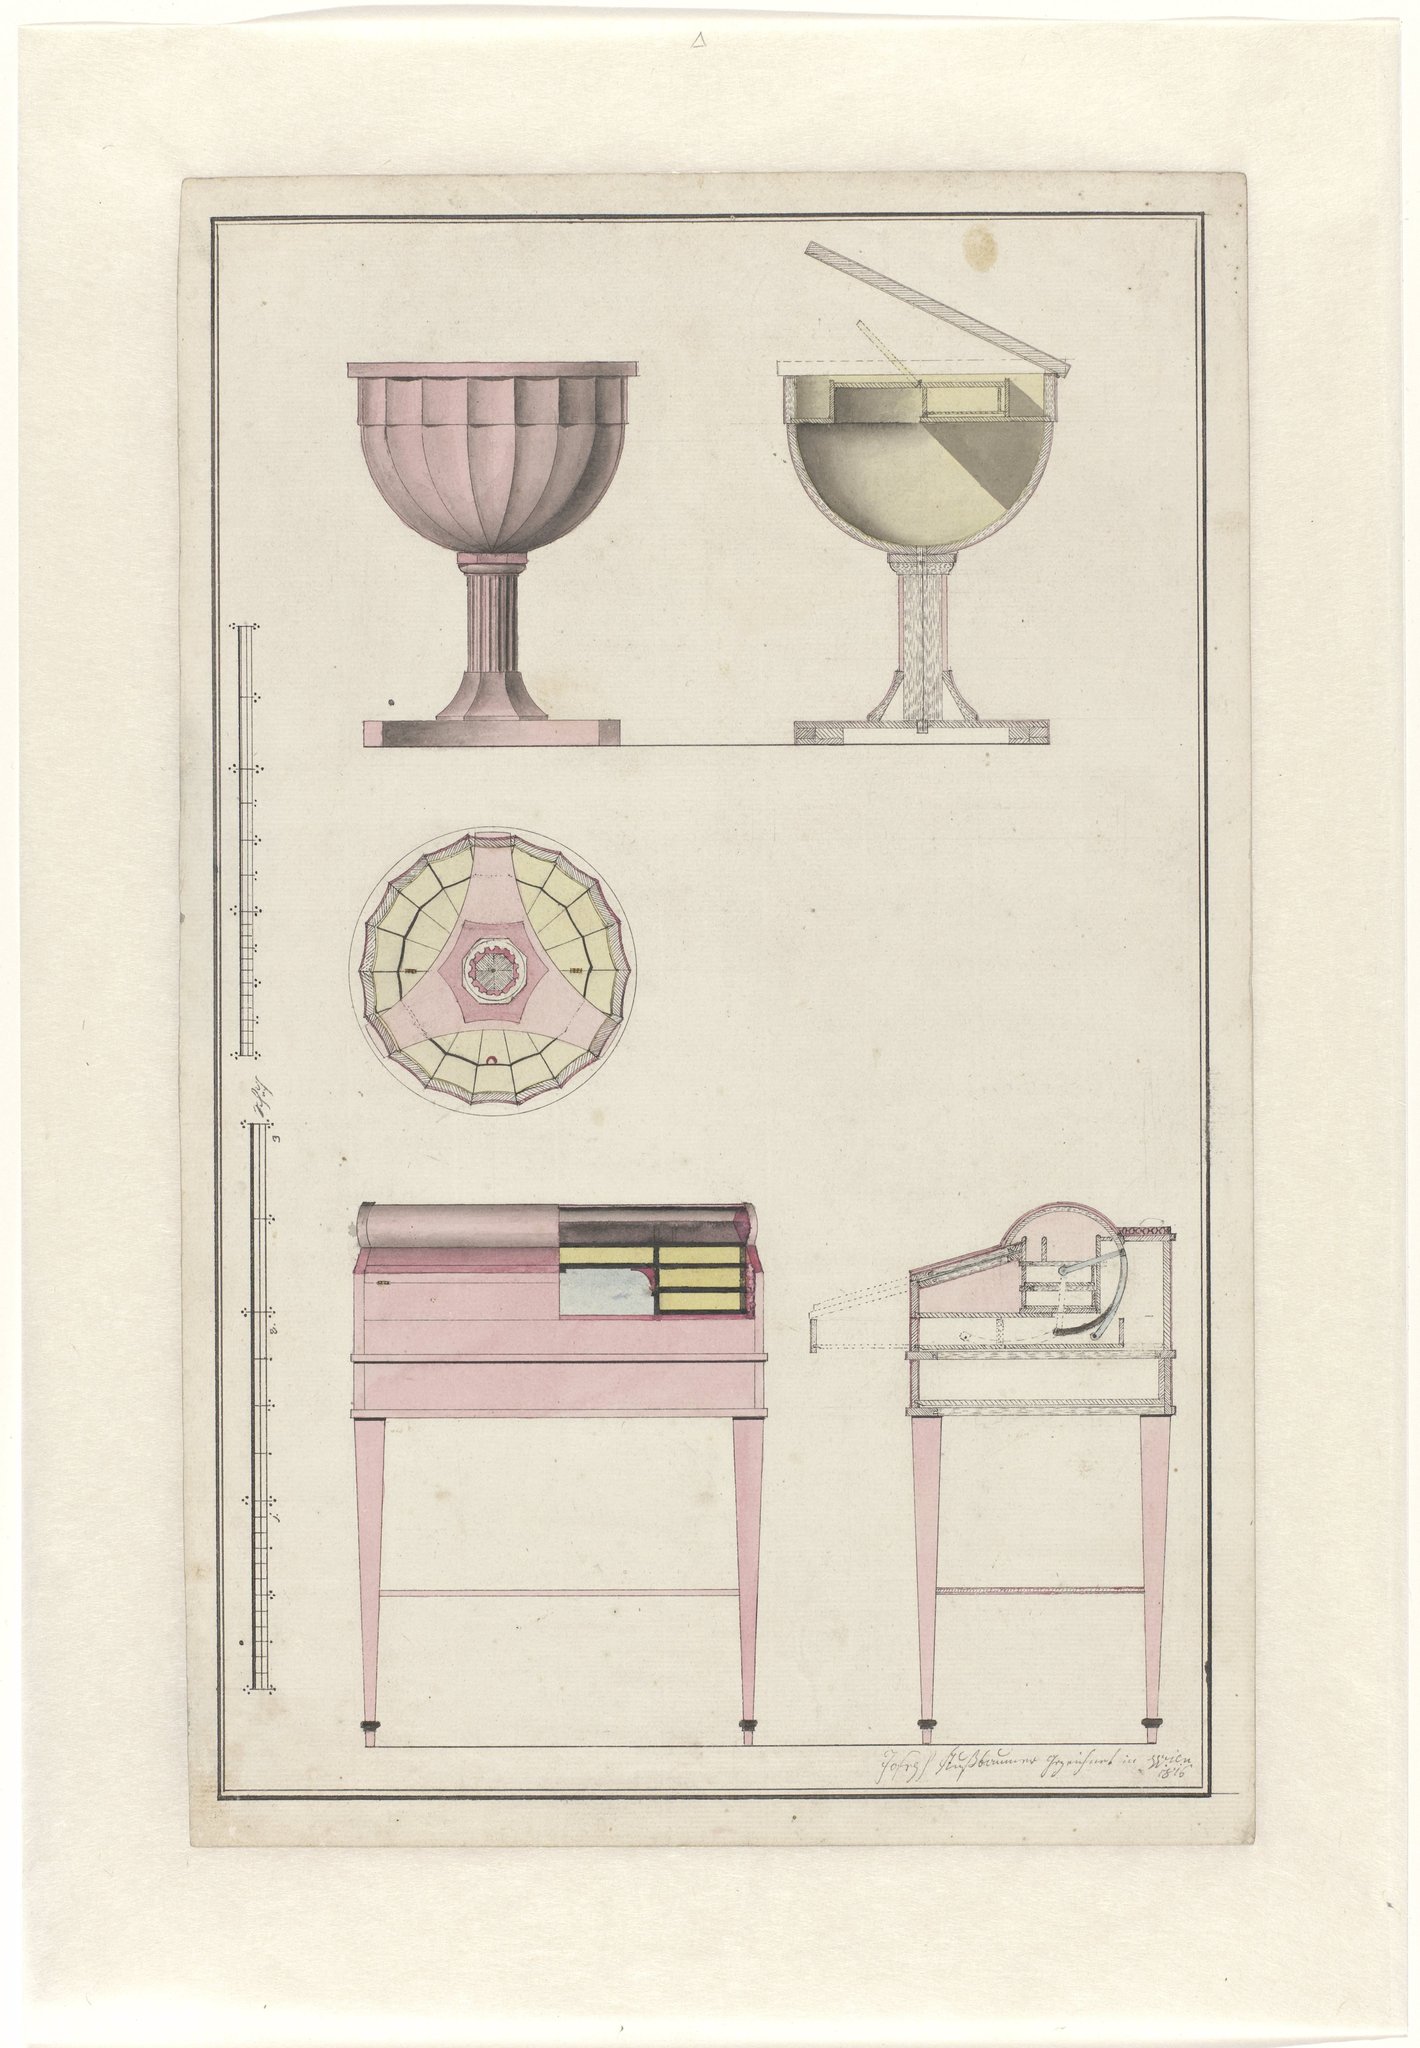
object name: design drawing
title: Ontwerp voor ronde naaitafel en bureau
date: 1816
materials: ink, paper, watercolor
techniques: brush, pen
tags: writing-table, writing-desk, furniture for storage, sewing box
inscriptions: inscription: ‘Ein Schreibtisch / mit Aufsatz ./ und ein’, number, watermark, signature and date: ‘Joseph Nussbaumer [...] in Wien / 1816’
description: Verso een schets van de bovenzijde van de secretaire met klok, met opschrift.